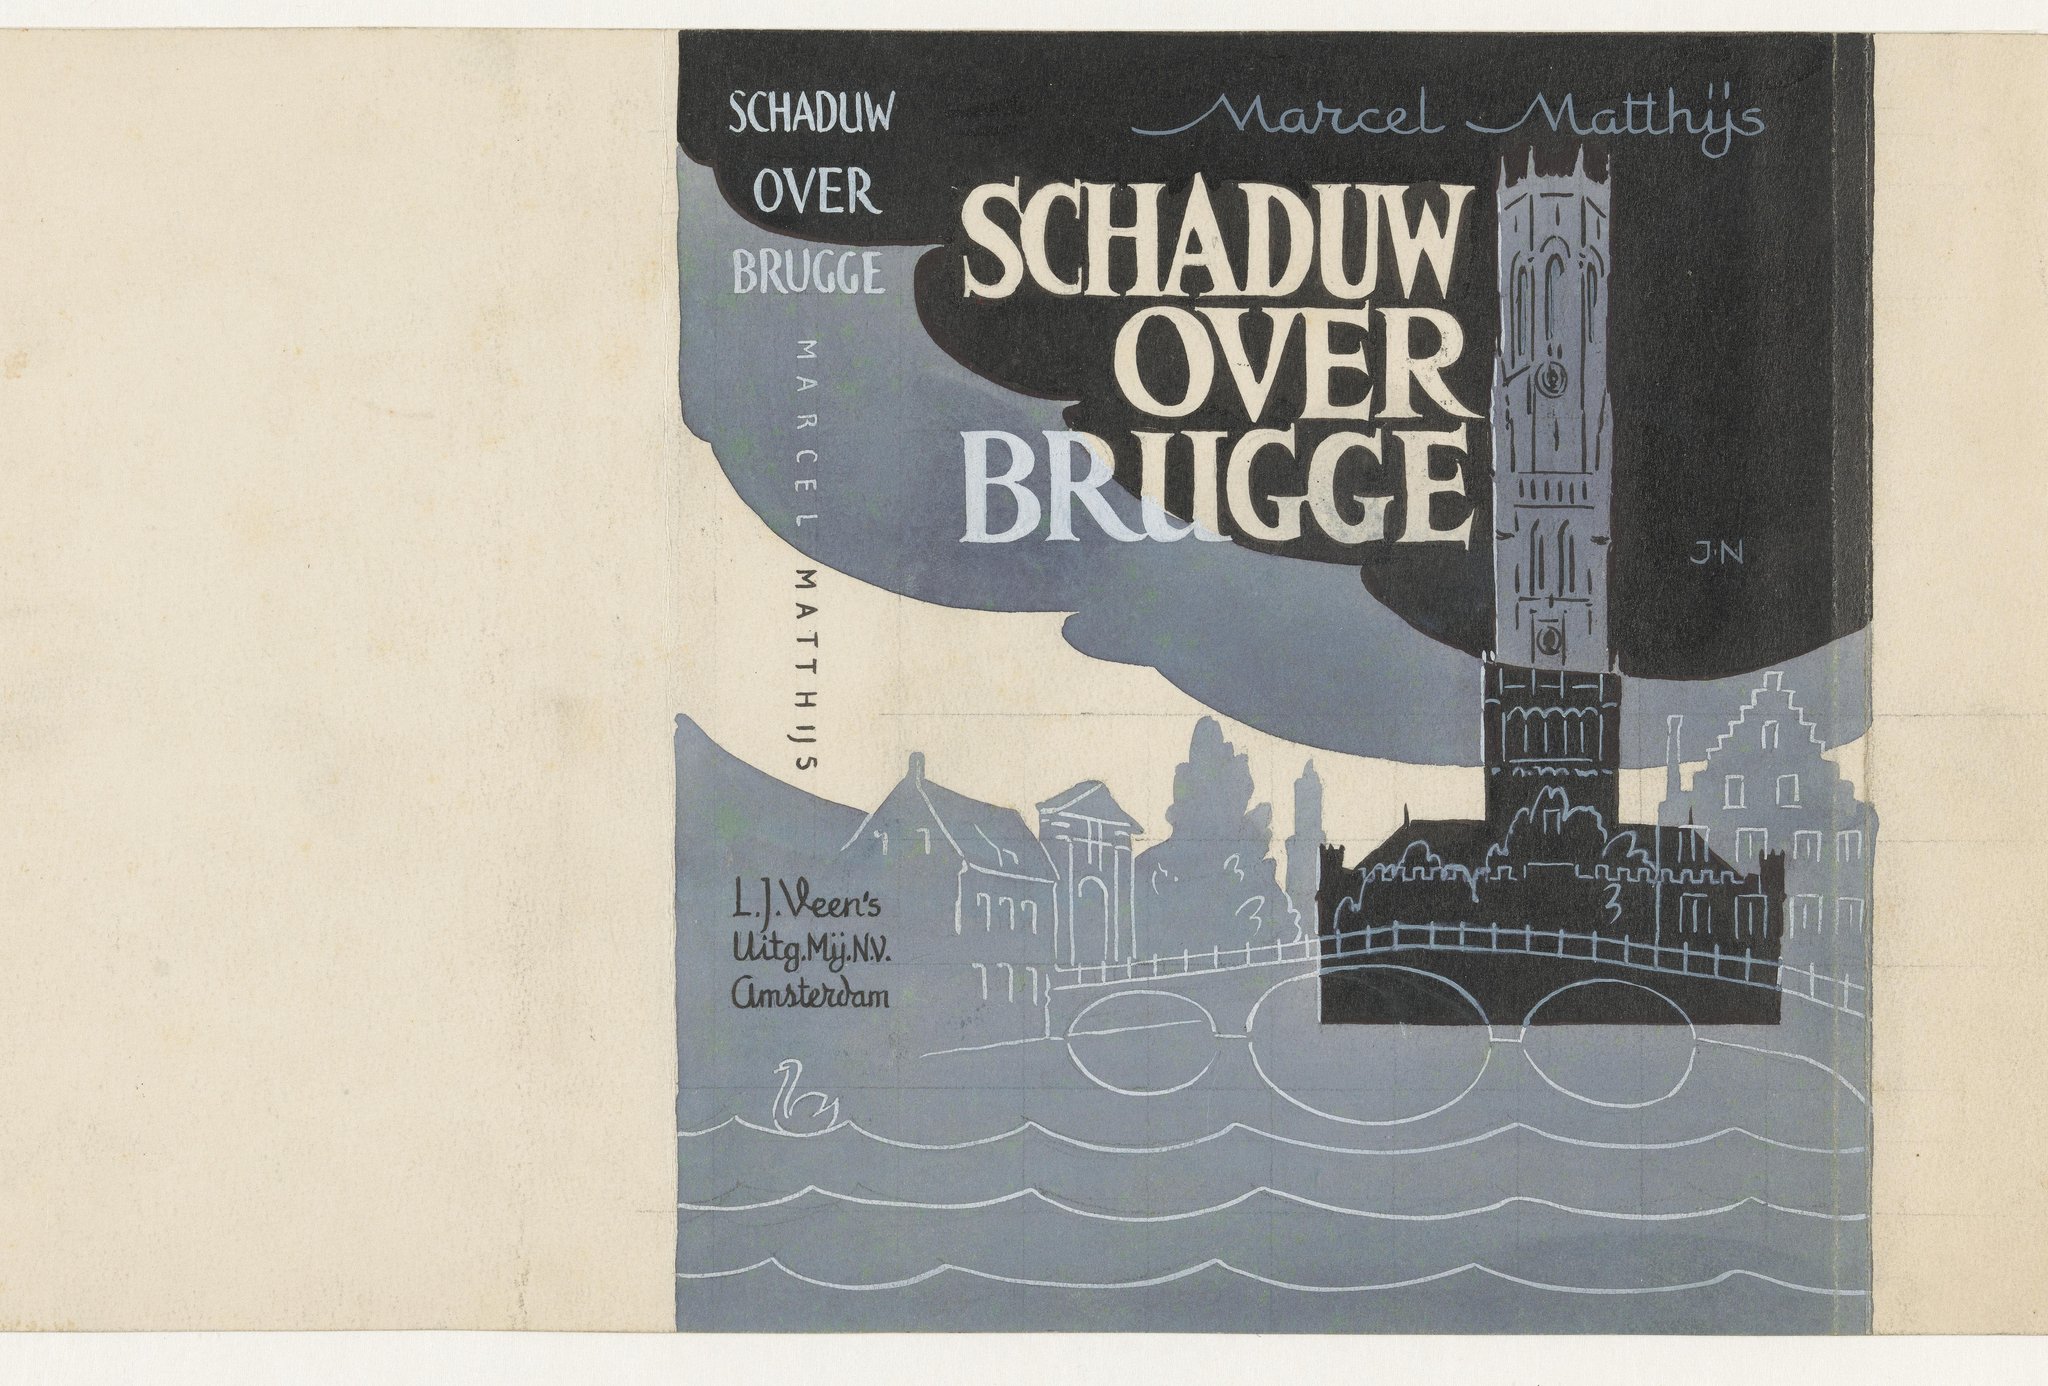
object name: drawing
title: Bandontwerp voor: Marcel Matthijs, Schaduw over Brugge, 1940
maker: jac nuiver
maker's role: grafisch ontwerper, illustrator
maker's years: 1892-1953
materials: paint, ink, paper, pencil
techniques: brush, pen, drawing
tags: tower, clock tower ~ monumental adornment, bridge in city across river, canal, etc.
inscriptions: signature: ‘J.N.’, workshop stamp: ‘ontwerp: jac. nuiver/ noorder amstellaan 127 amsterdam/ telefoon 21254 postrekening 81326’, collector's mark: Lugt 2228a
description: Gezicht op het Belfort van Brugge met in de voorgrond een brug over het water.